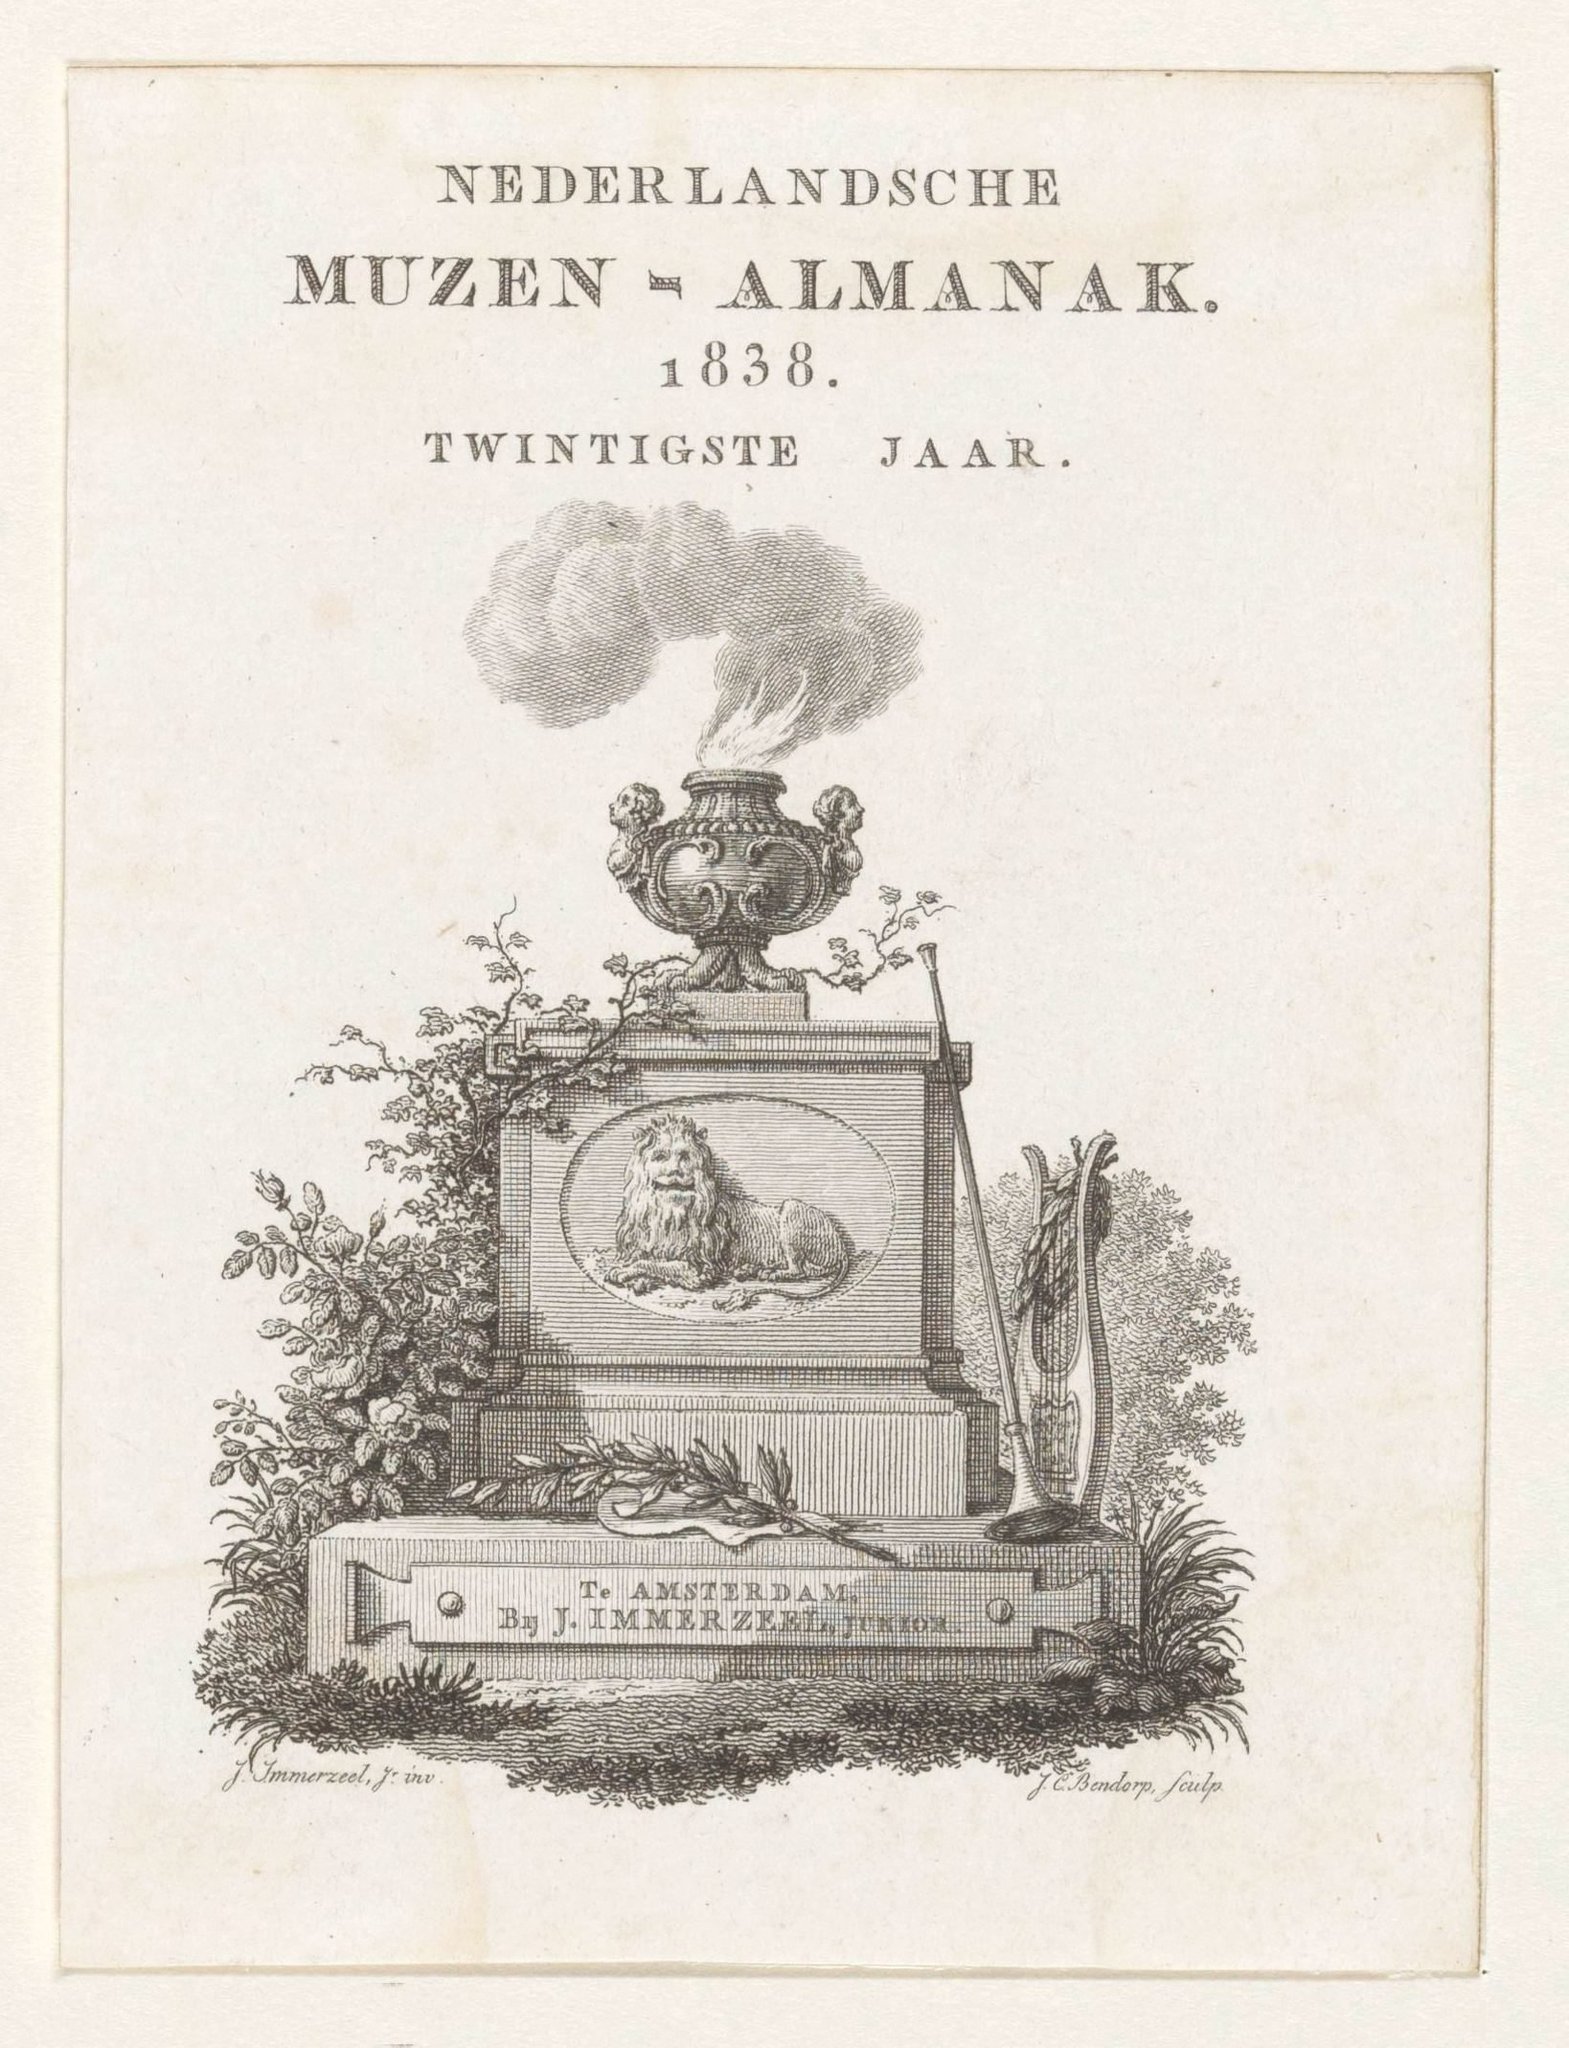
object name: print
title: Monument met brandend wierookvat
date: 1838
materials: paper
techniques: engraving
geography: amsterdam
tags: incense-burner ~ scents, perfumes, symbols of particular nations, states, districts, etc.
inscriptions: collector's mark: Lugt 2228, collector's mark: Lugt 2760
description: Titelpagina voor: S.n. Nederlandsche muzen-almanak. Rotterdam: Immerzeel, Johannes, 1838.